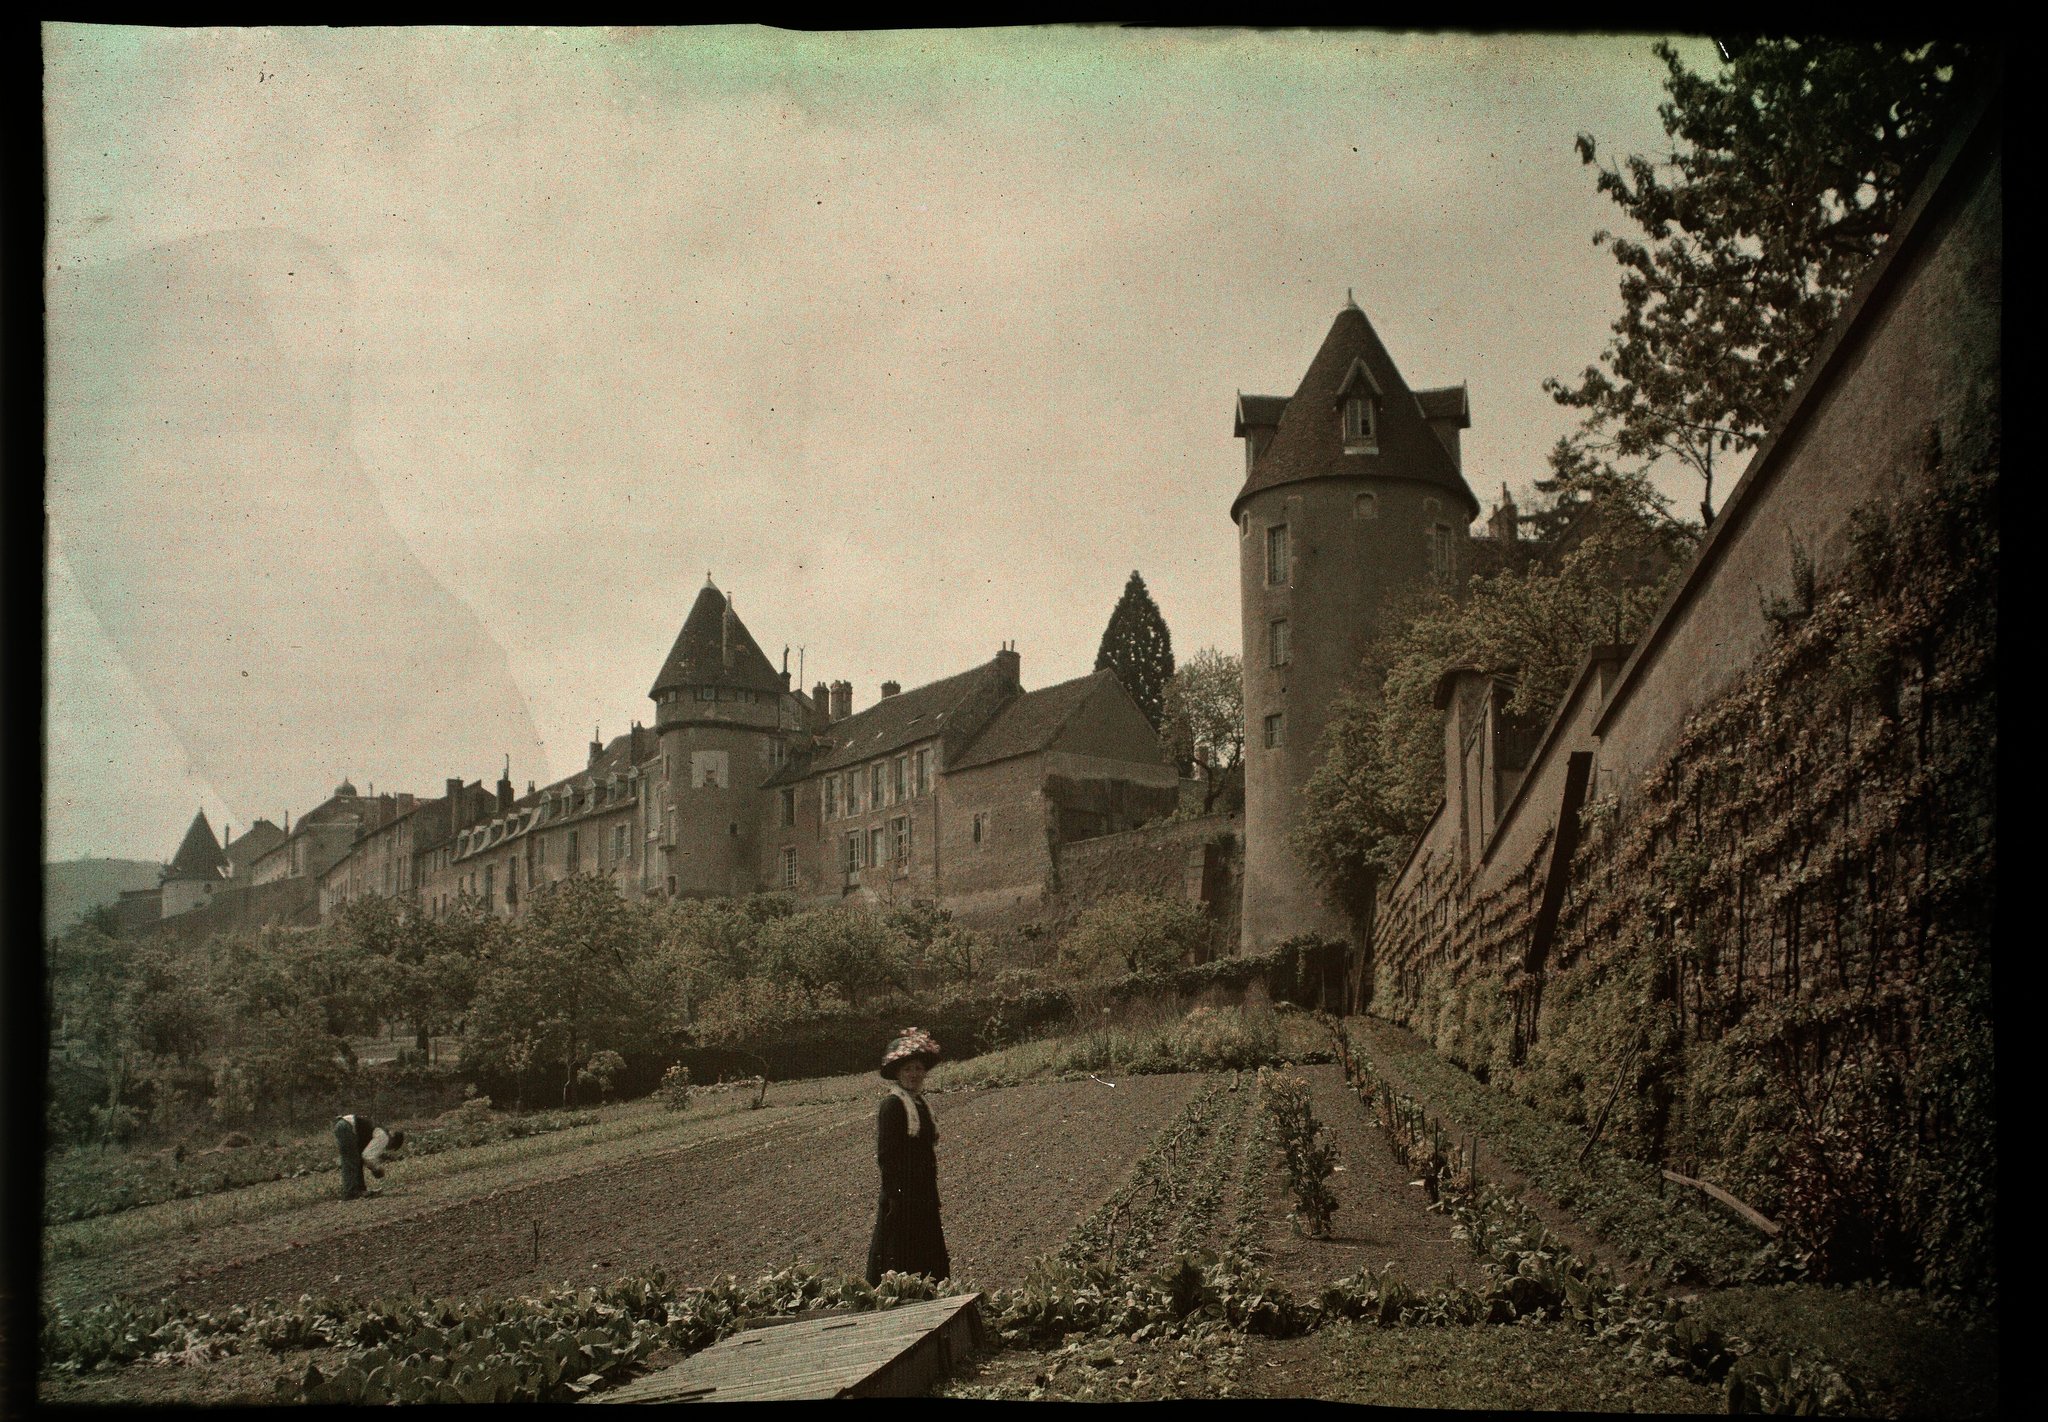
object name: color slide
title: Vrouw bij vestingmuur van een onbekende stad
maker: Anonymous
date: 1907-1930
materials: glass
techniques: autochrome process, slide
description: Gezicht op een tuin aan de landzijde van een vestingwal, met een staande vrouw, met hoed, en een voorover gebogen staande man.